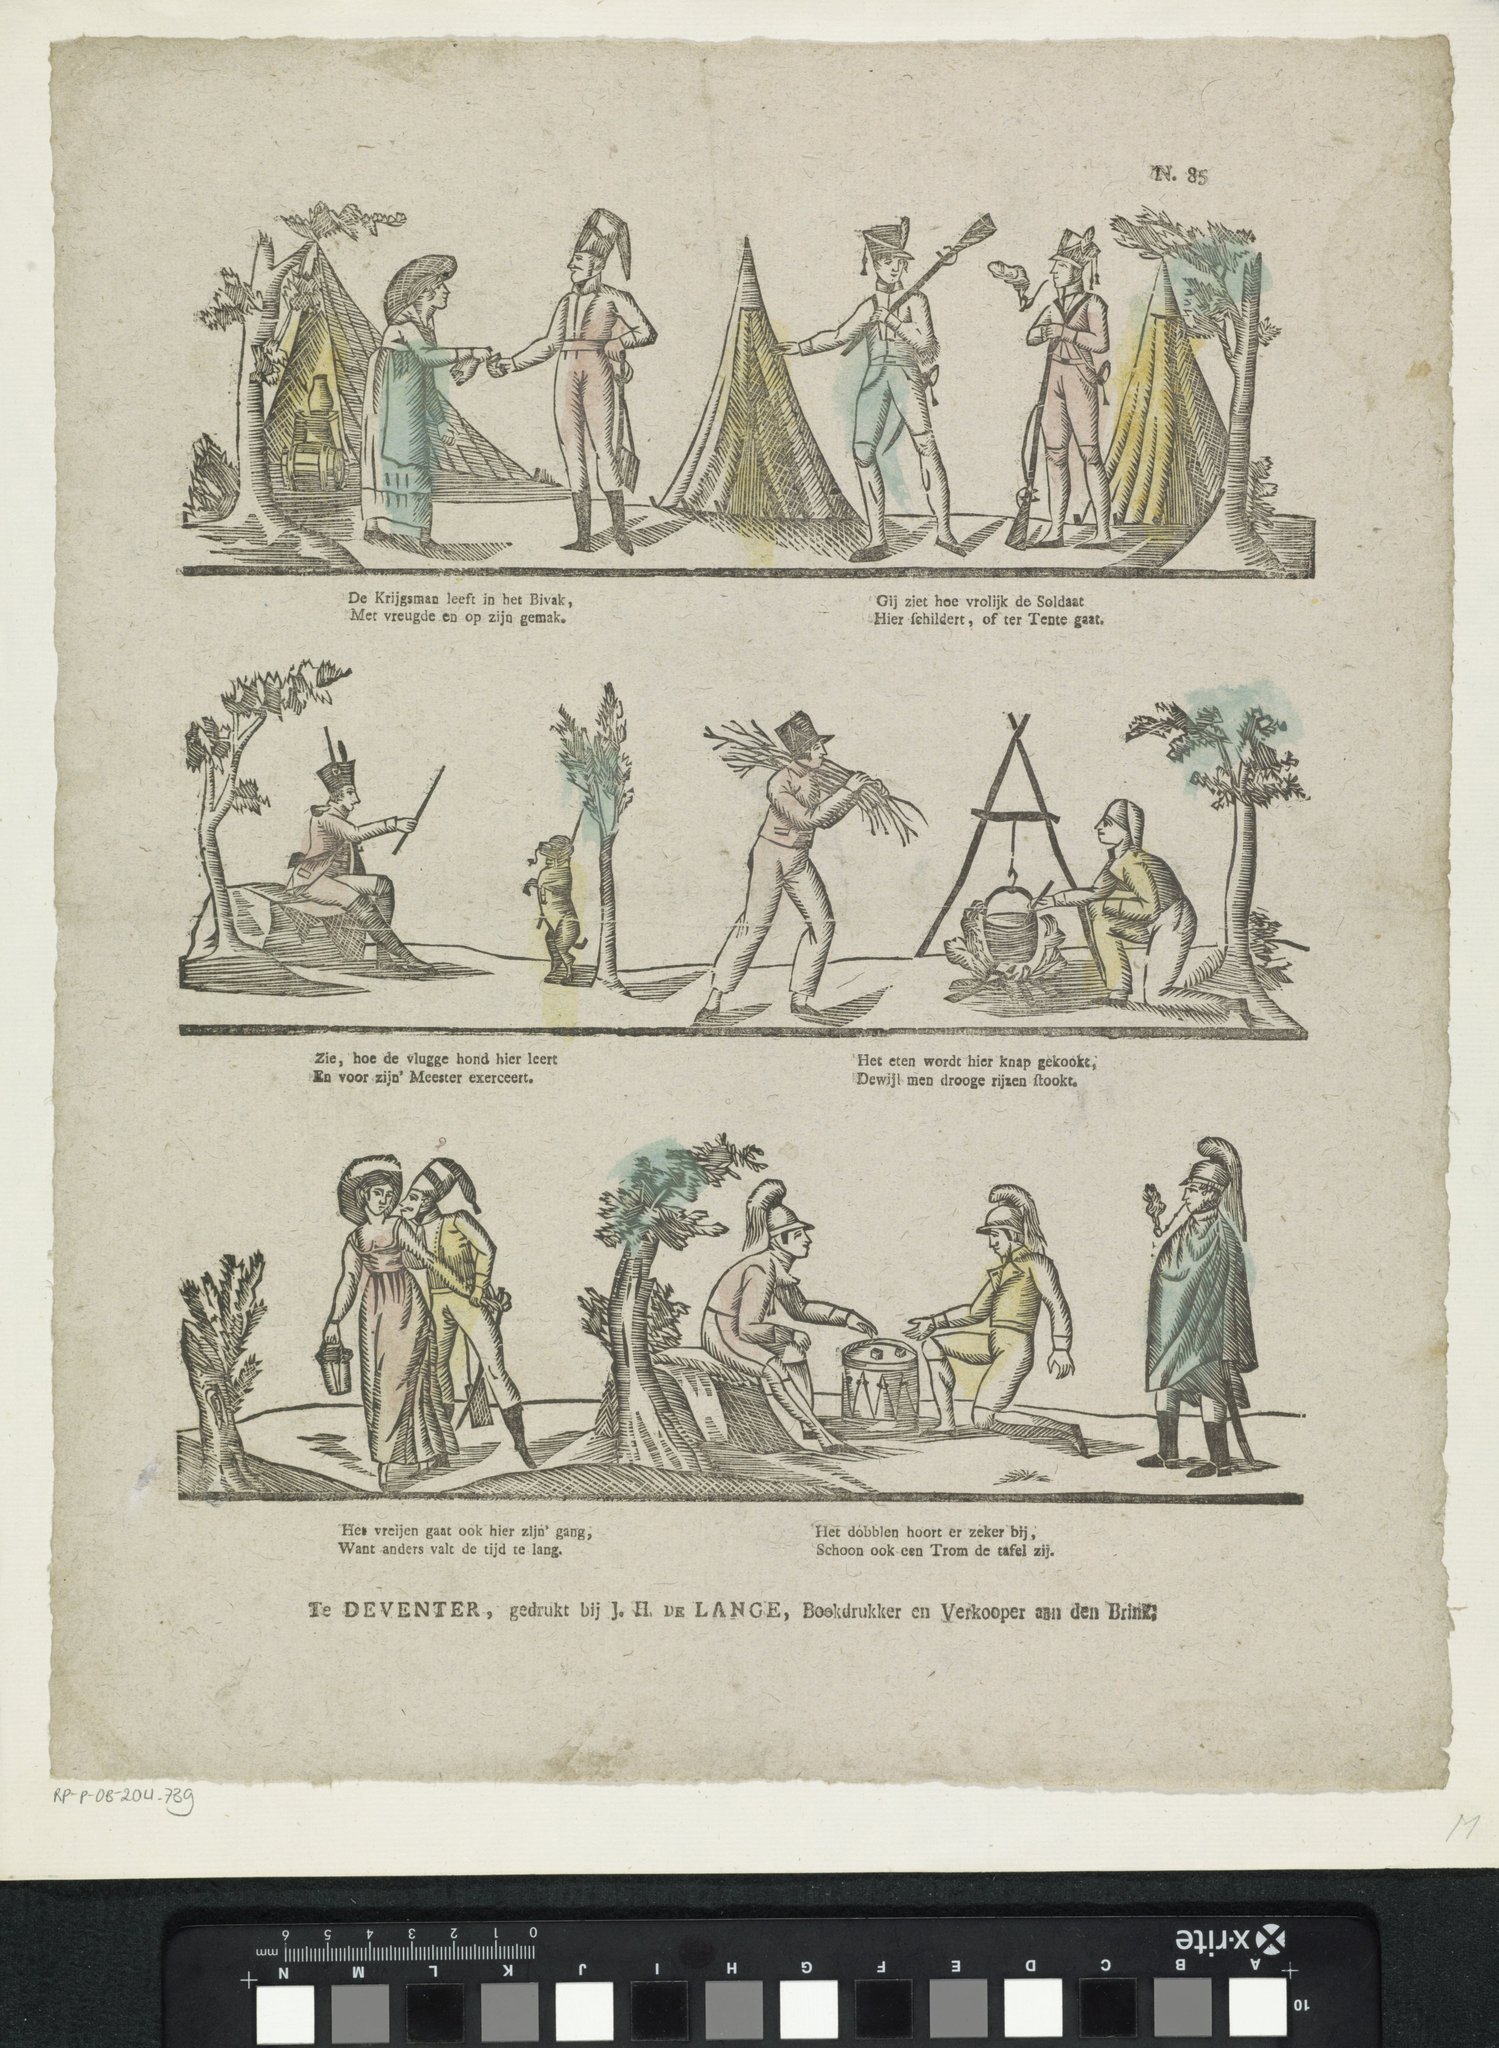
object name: popular print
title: Militairen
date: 1787-1822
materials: paper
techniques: colour, letterpress printing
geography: netherlands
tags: leave ~ the soldier off duty, the soldier; the soldier's life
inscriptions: collector's mark: Lugt 2760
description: Blad met 3 horizontale rijen met voorstellingen van militairen die een hond trainen, die dobbelen en die vrijen met hun liefje. Onder elke rij een vierregelig vers in twee kolommen. Genummerd rechtsboven: N. 85.